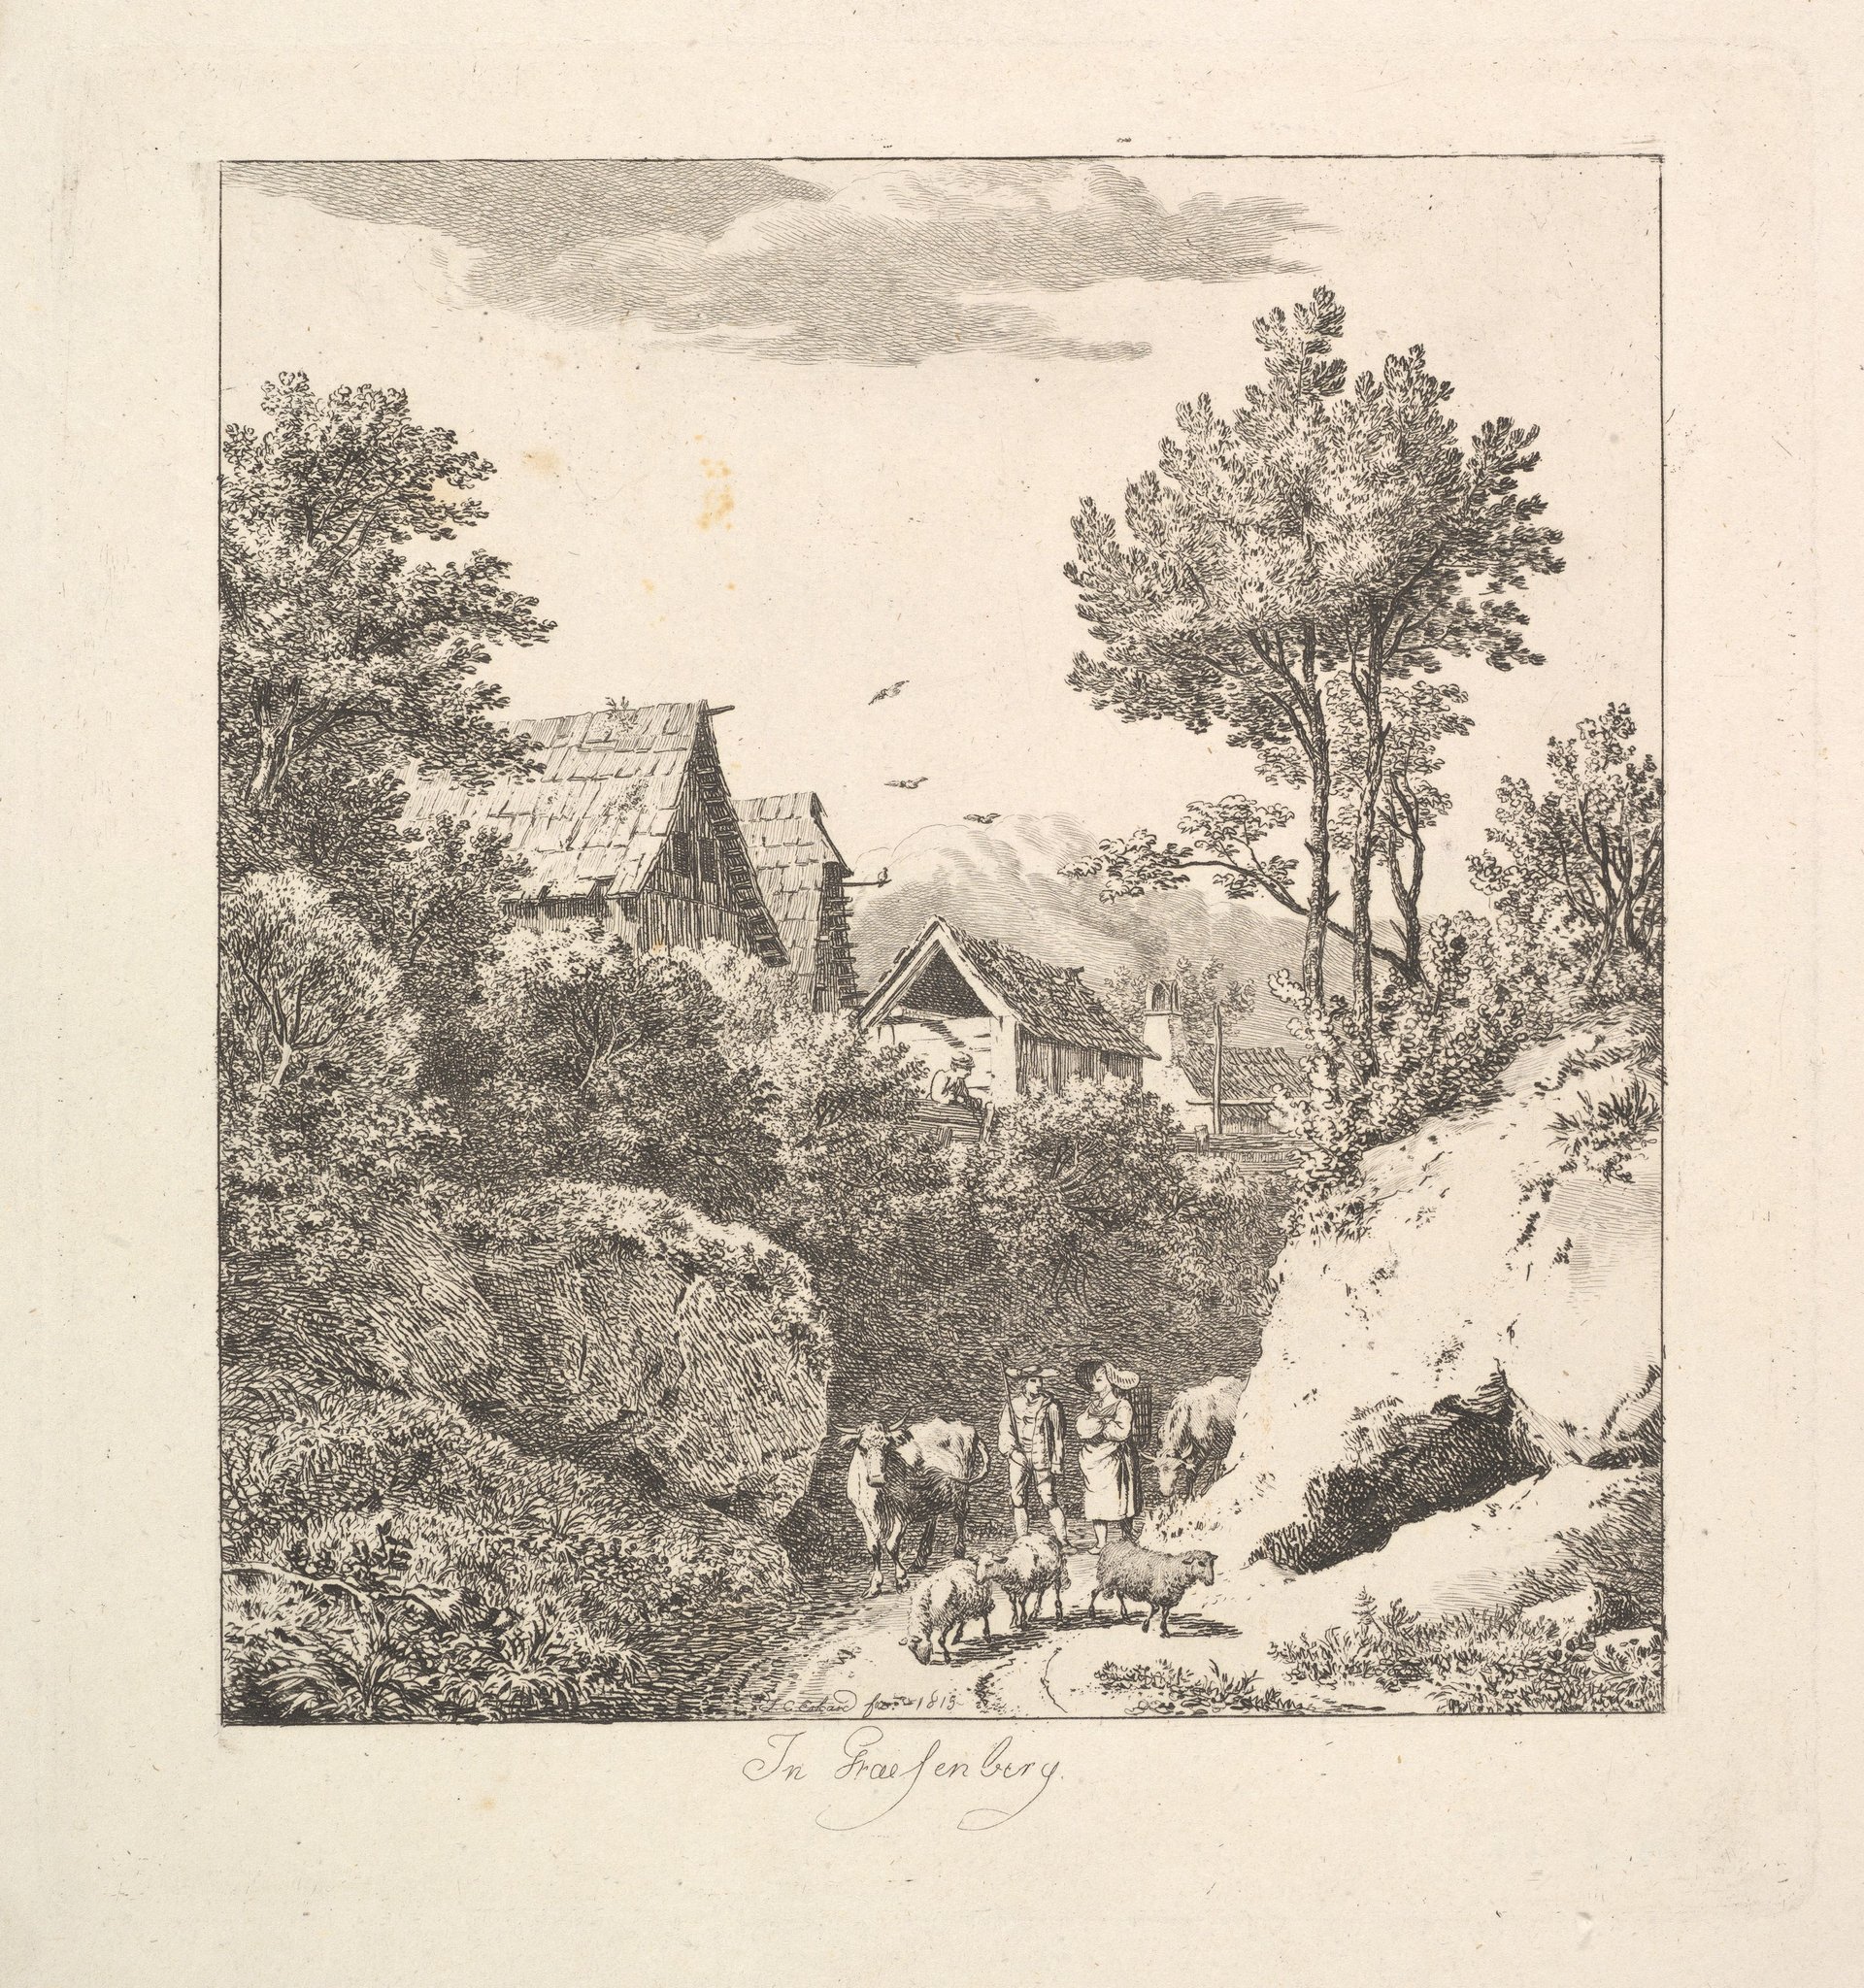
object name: print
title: In Regenberg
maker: johann christoph erhard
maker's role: artist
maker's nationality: german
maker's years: 1795-1822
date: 1815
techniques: etching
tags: houses,men,cows,sheep,trees